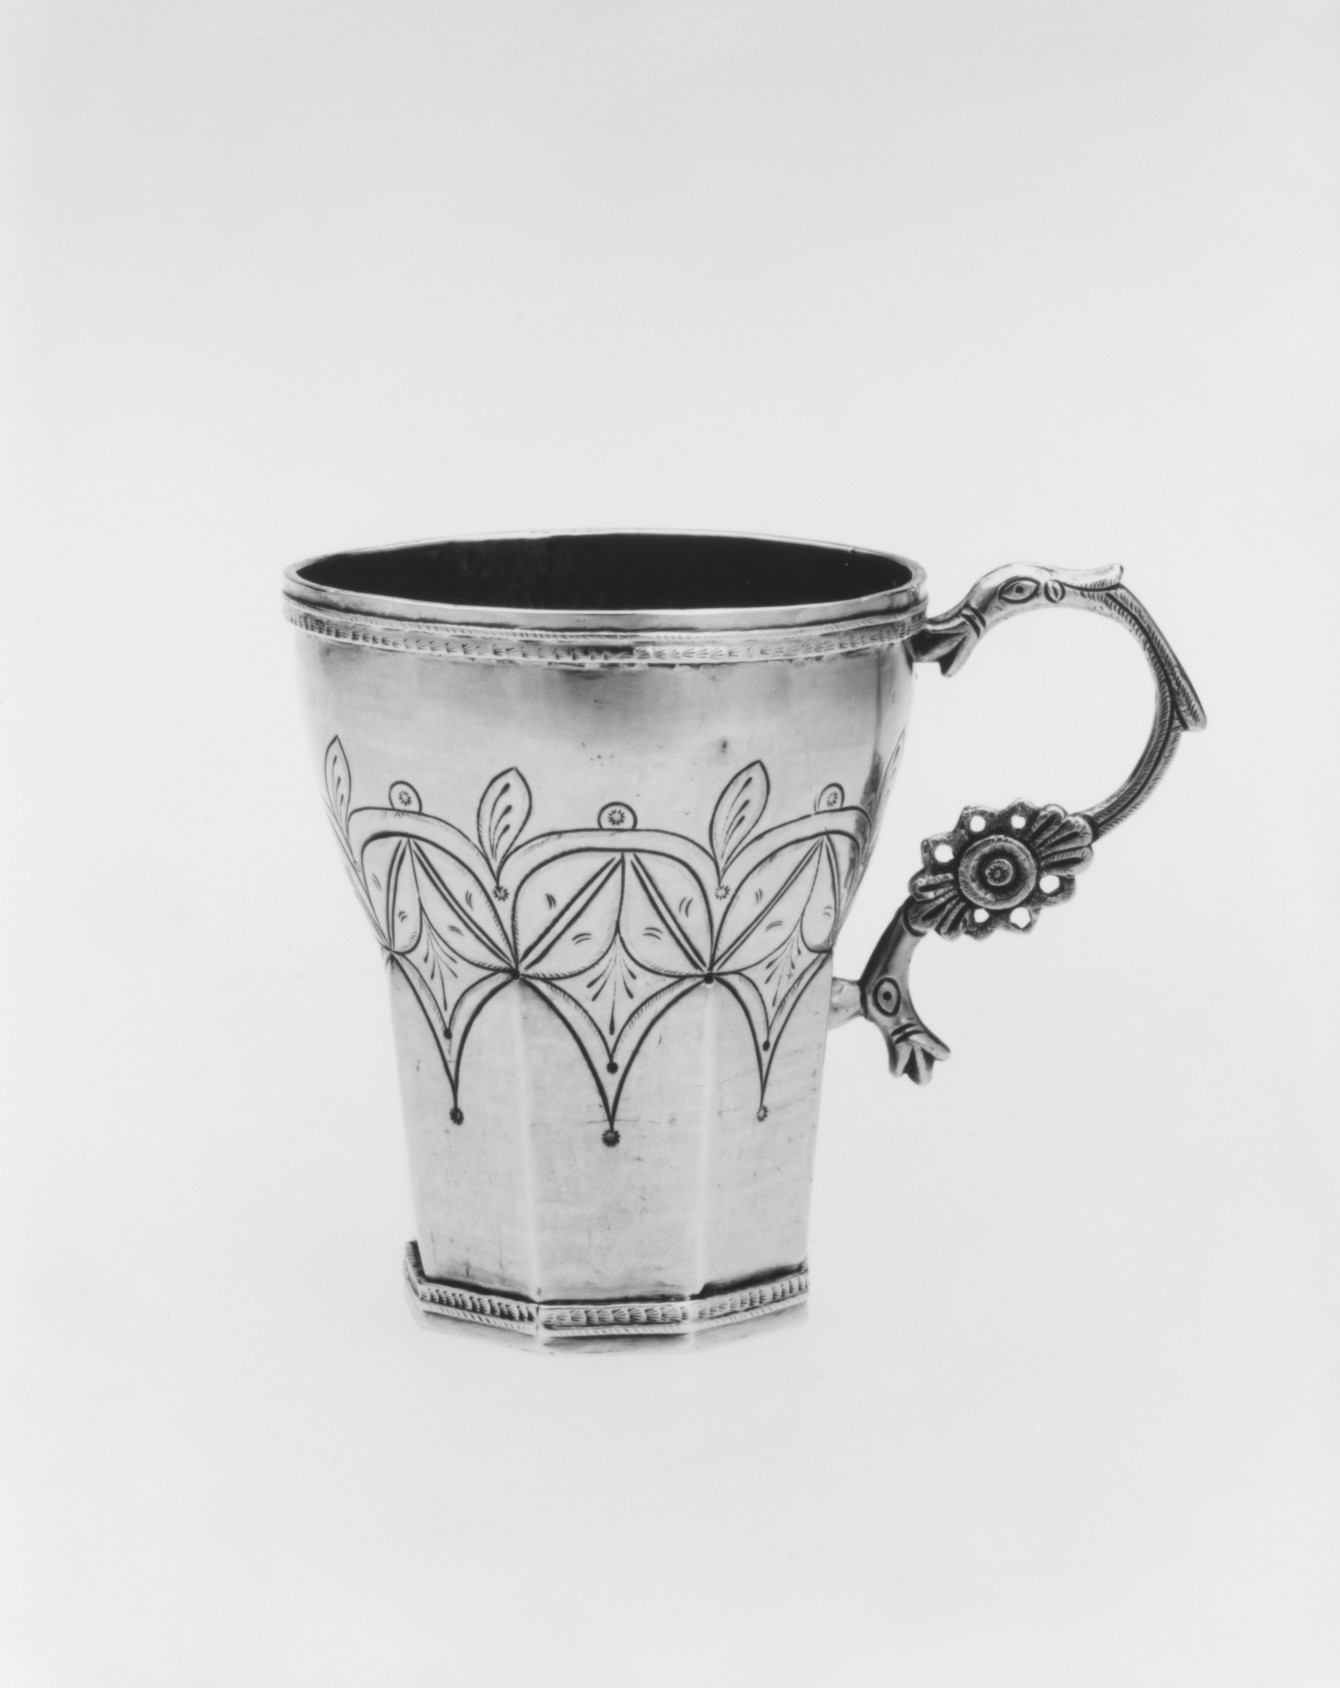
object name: mug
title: Mug (one of a pair)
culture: south american, bolivian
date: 1701-1800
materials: silver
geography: bolivia